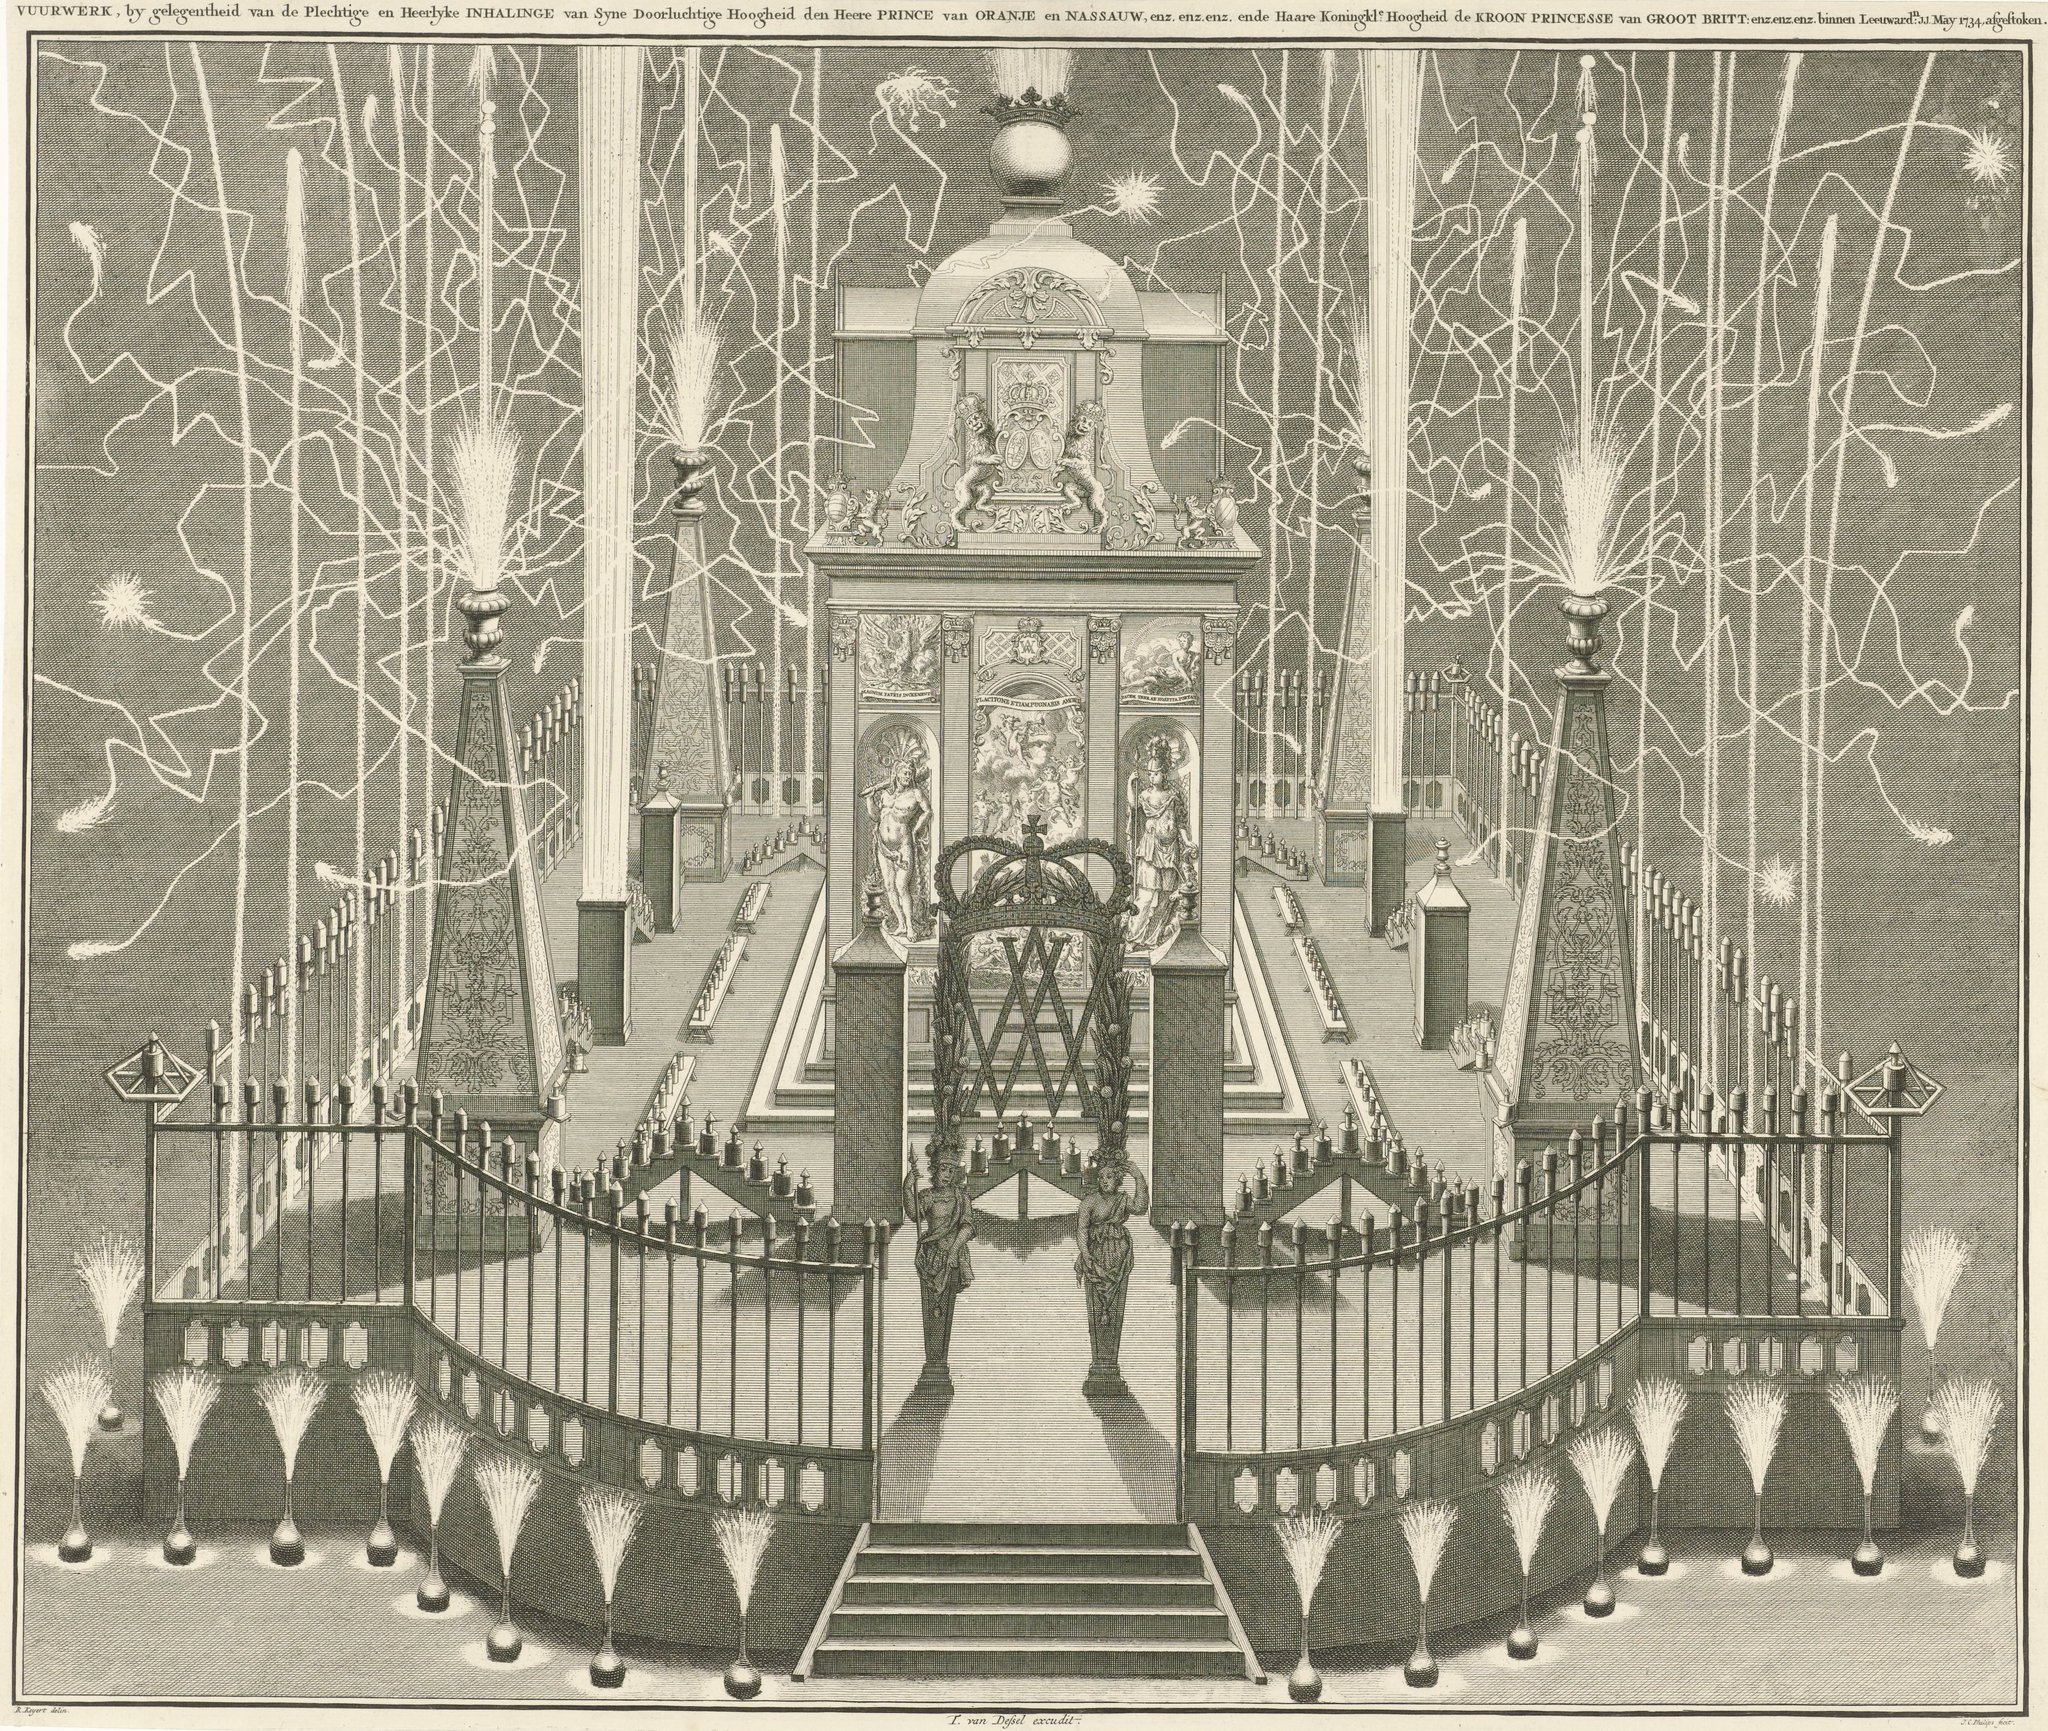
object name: print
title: Vuurwerk, by gelegentheid van de Plechtige en Heerlyke Inhalinge van Syne Doorluchtige Hoogheid den Heere Prince van Oranje en Nassauw, enz.enz.enz. ende Haare Koningkle: Hoogheid de Kroon Princesse van Groot Britt: enz.enz.enz. binnen Leeuwardn: 11 May 1734, afgestoken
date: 1734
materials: paper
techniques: engraving, etching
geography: amsterdam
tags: willem iv (prins van oranje-nassau), the hague, anna van hannover, public festivities at marriage of royal persons (+ illumination, fire-works ~ festive activities)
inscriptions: collector's mark: Lugt 2228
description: Vuurwerk aangericht te Leeuwarden op 11 mei 1734 ter gelegenheid van de inkomst van het pasgetrouwde paar prins Willem IV en prinses Anna, gehuwd op 25 maart 1734. Centraal een tempel versierd met allegorische figuren, vooraan een poort met een monogram van de vervlochten letters W en A.